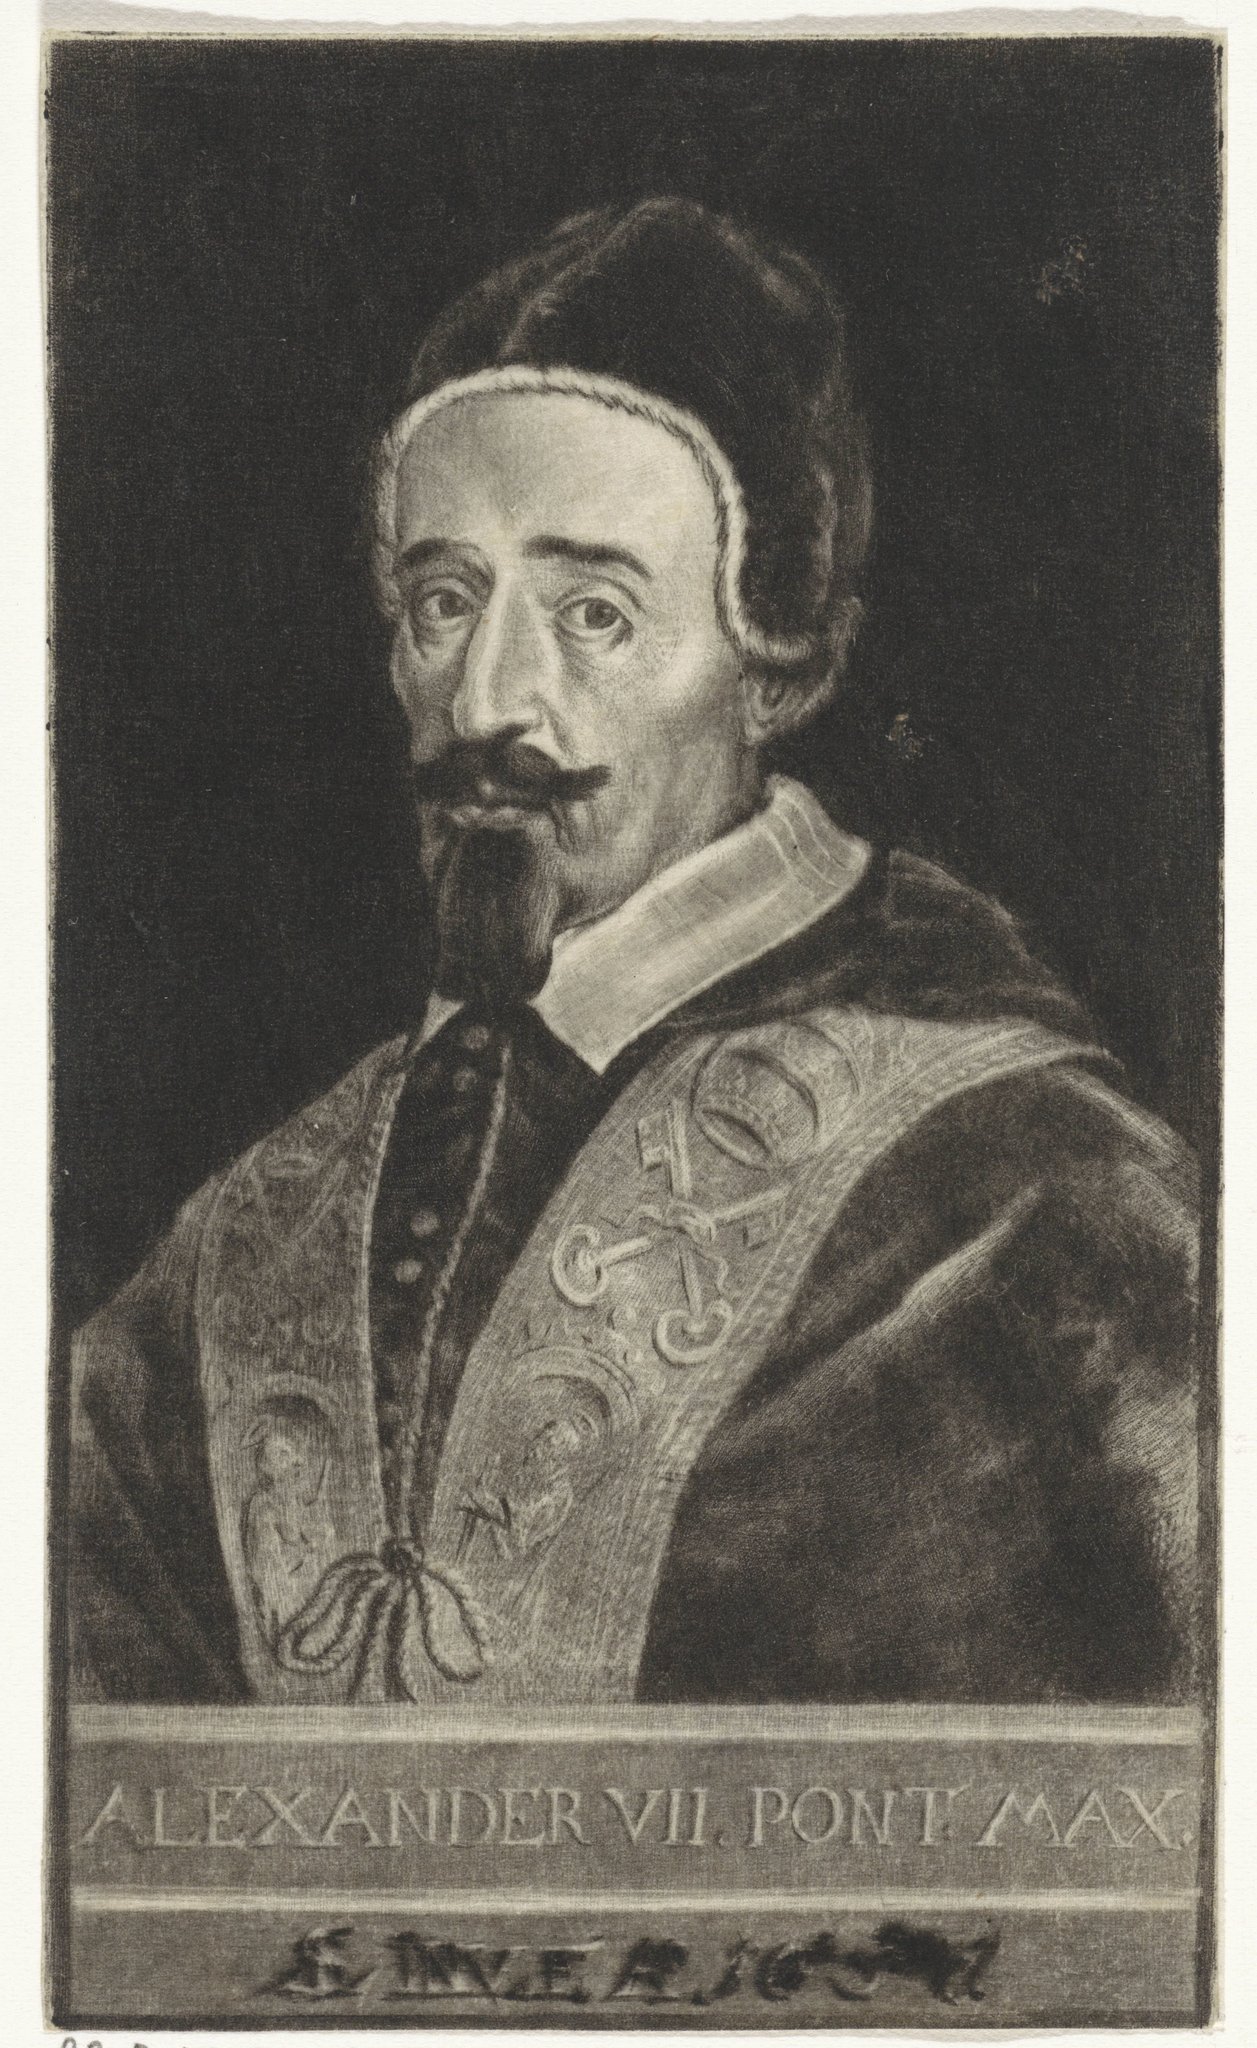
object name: print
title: Portret van paus Alexander VII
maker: ludwig von siegen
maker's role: print maker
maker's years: 1609-1680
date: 1657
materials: paper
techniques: etching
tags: rome, alexander vii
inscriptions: collector's mark: Lugt 2228